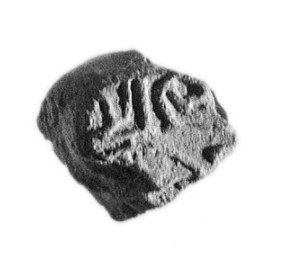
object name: sealing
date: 1981-1640 BCE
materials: mud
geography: egypt